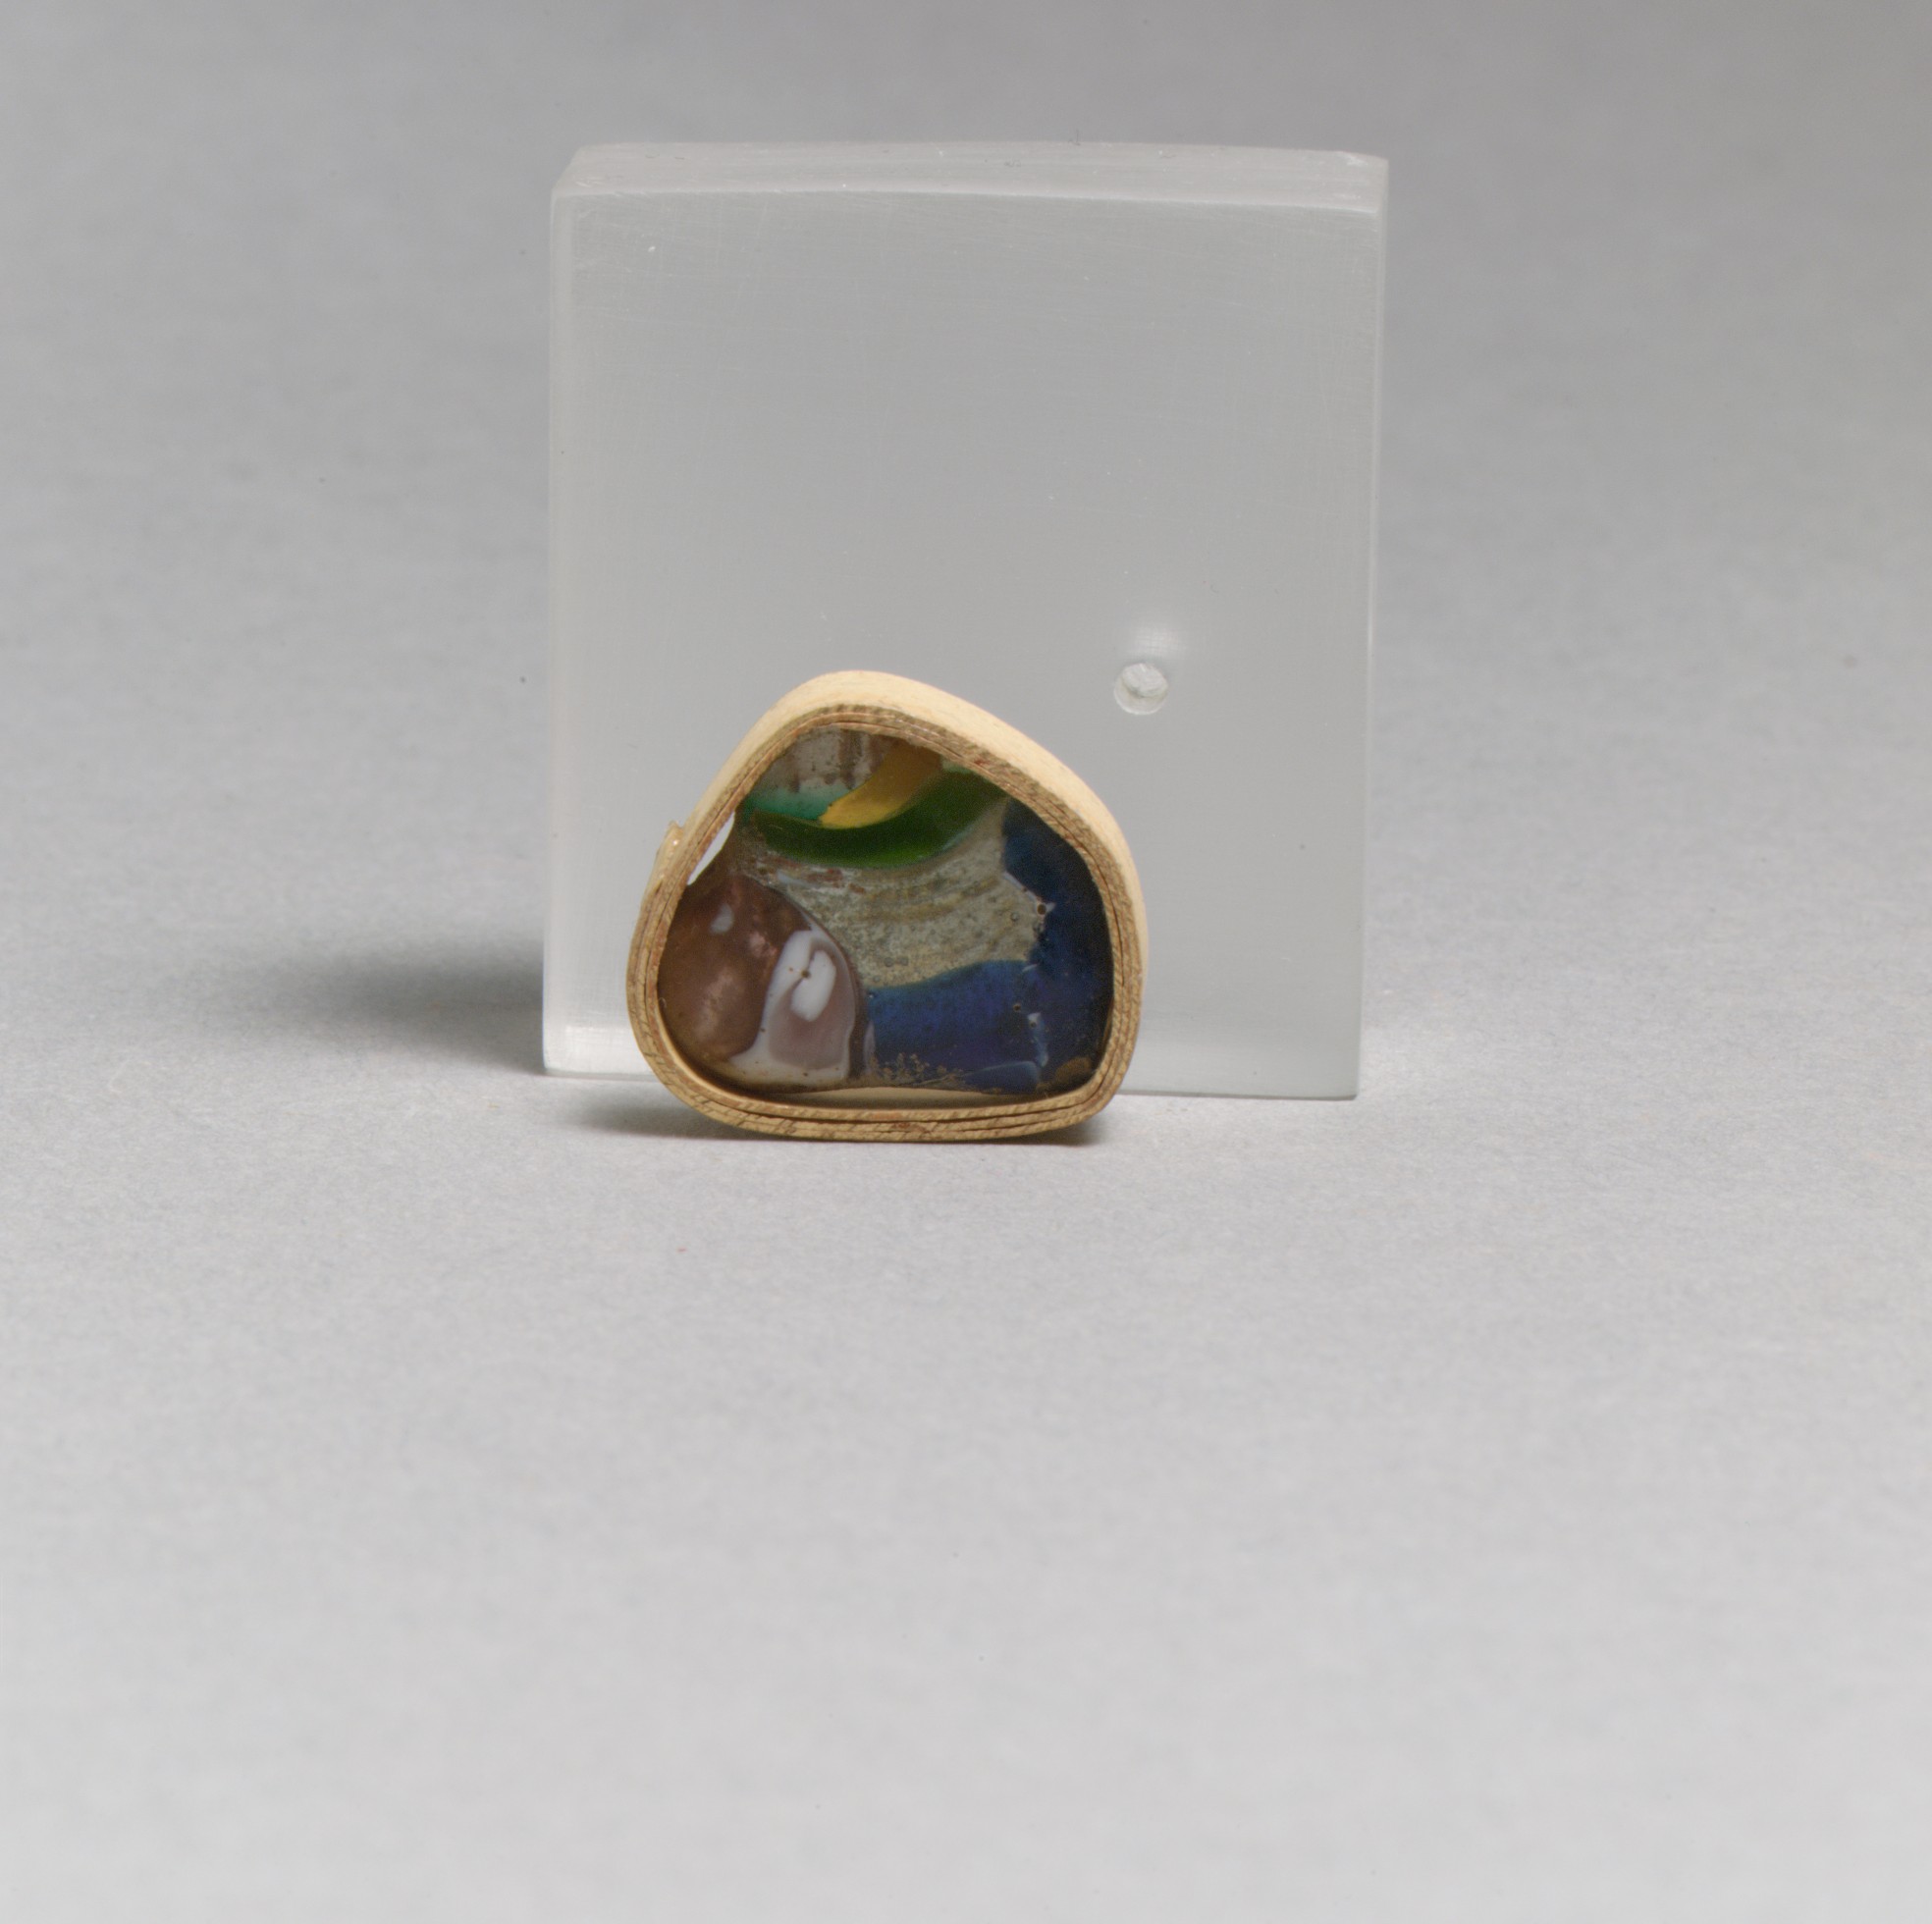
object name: fragment, mosaic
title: Glass mosaic fragment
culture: roman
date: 34 BCE-33 CE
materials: glass